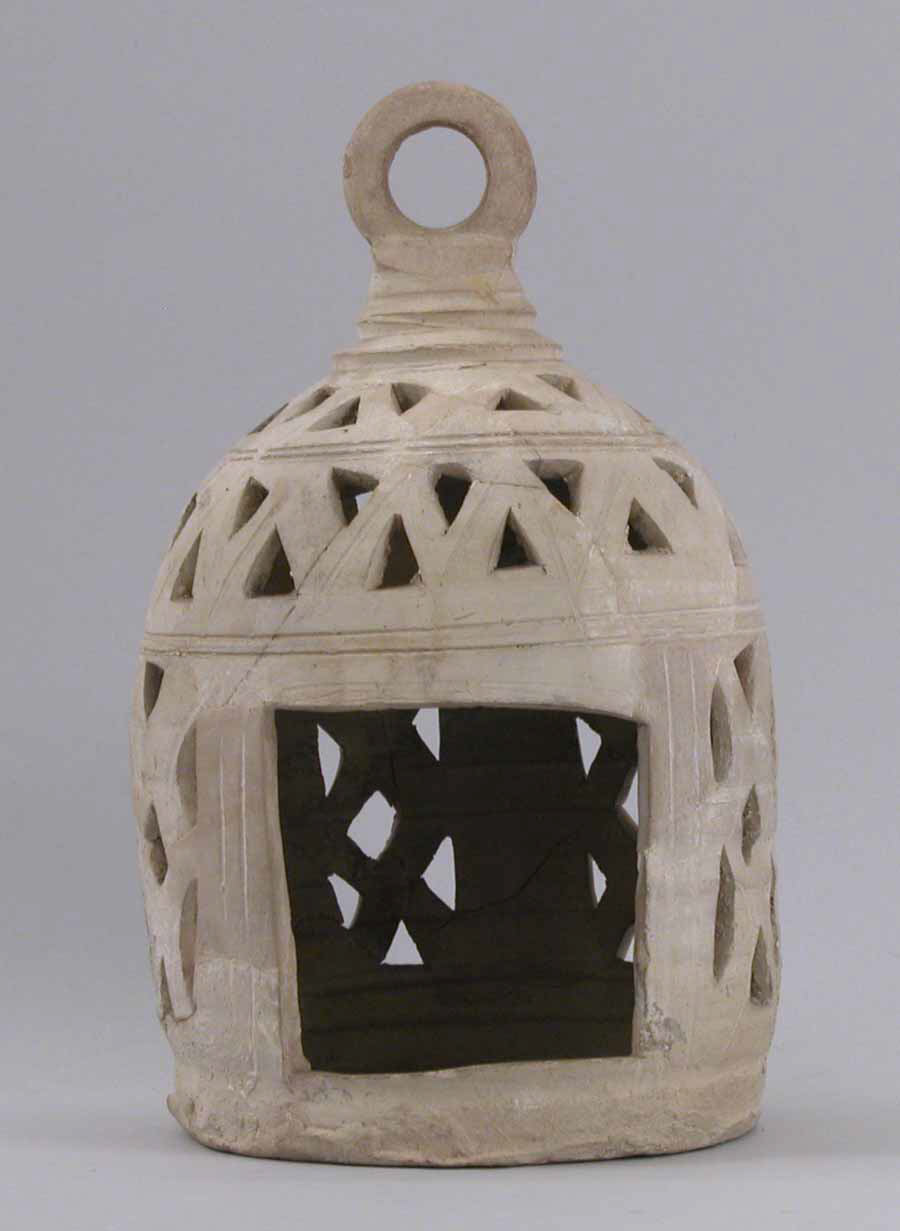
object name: lantern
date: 801-1000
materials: earthenware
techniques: carving, incising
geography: iran